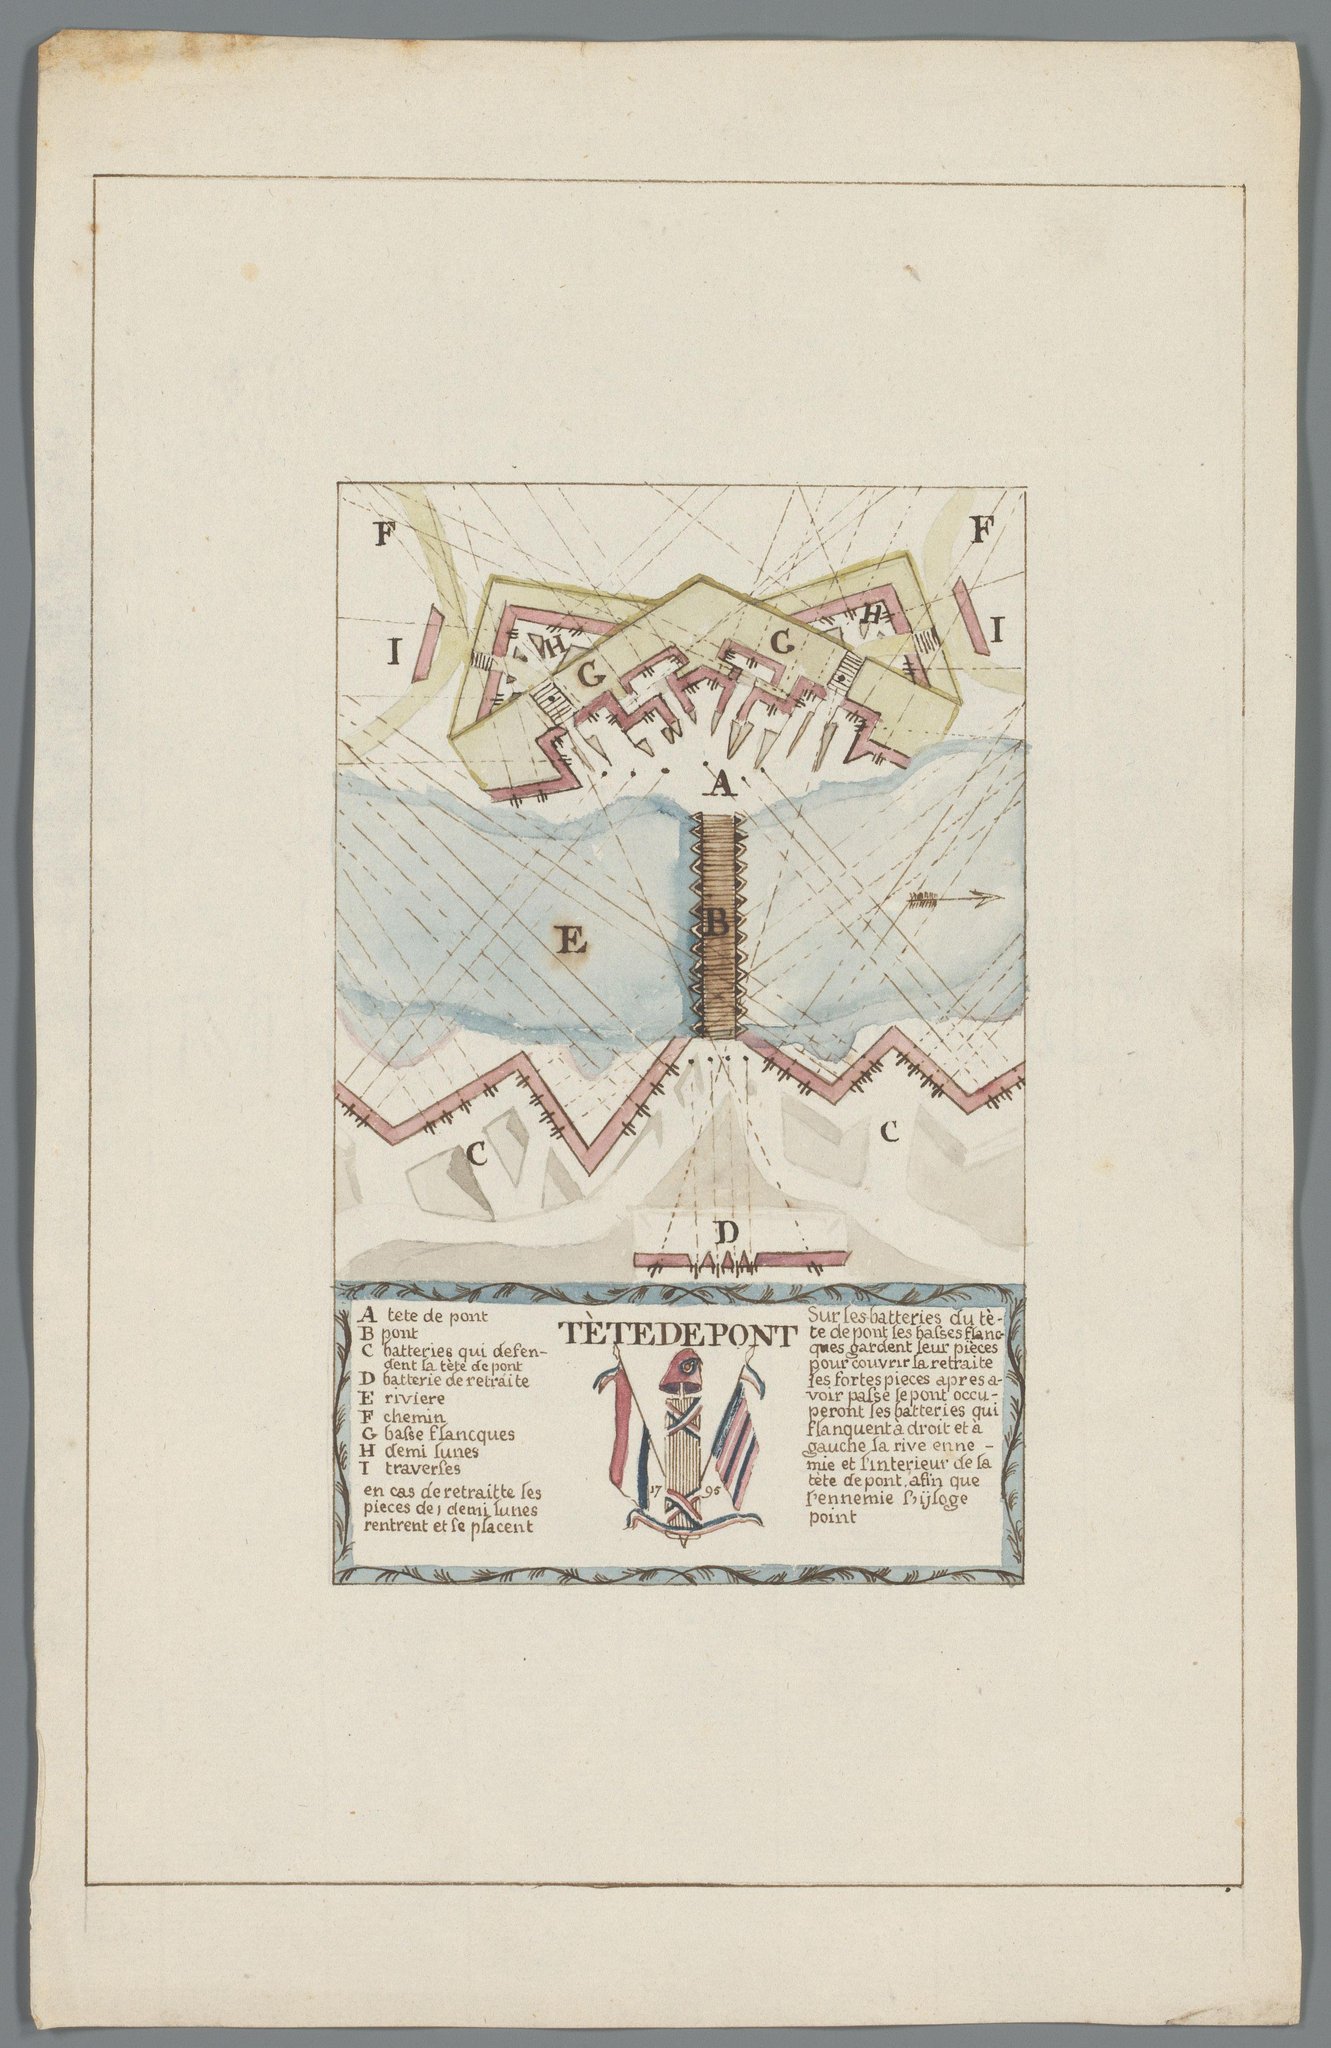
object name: drawing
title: Fortificaties rondom een schipbrug, 1795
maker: hendrik van der poth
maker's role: draughtsman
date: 1795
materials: paper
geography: netherlands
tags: fortifications, military engineering, pontoon bridge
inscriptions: date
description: Strategische tekening van fortificaties aan weerszijden van een rivier waarover een schipbrug is gebouwd, 1795.